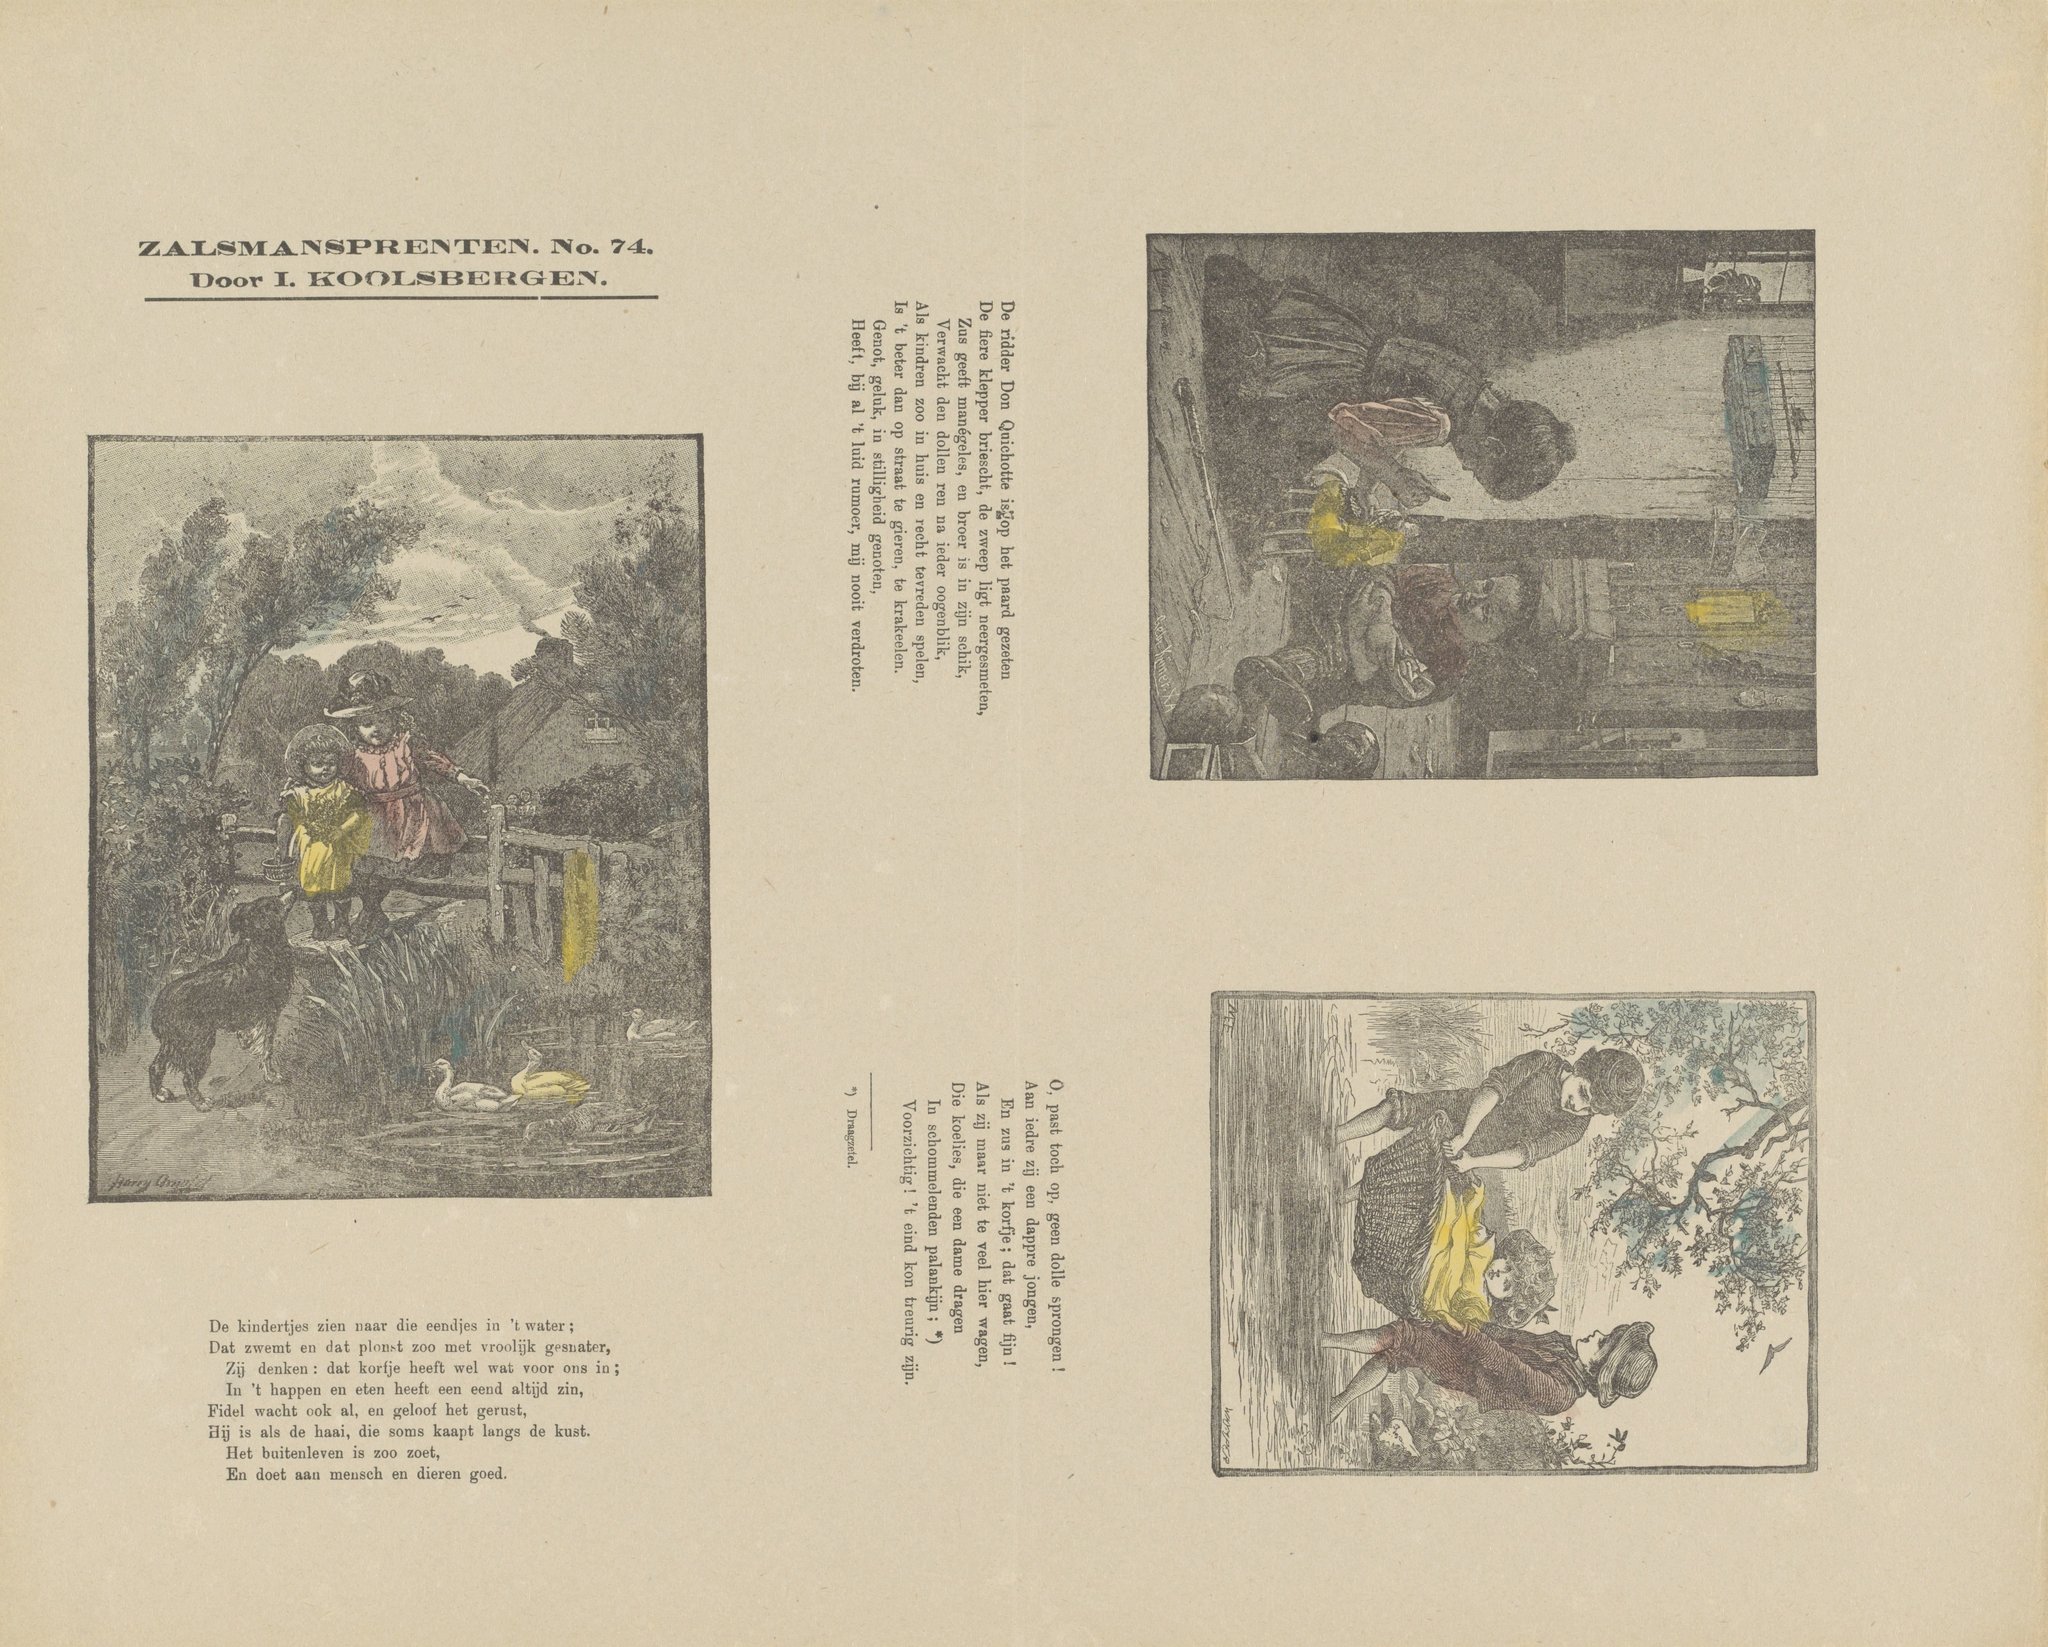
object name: popular print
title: Kindertaferelen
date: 1869-1882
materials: paper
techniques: colour, letterpress printing, engraving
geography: europe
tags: children's games and plays, child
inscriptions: collector's mark: Lugt 2760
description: Blad met 3 taferelen met kinderen. Onder elke afbeelding een onderschrift. Genummerd linksboven: No. 74.